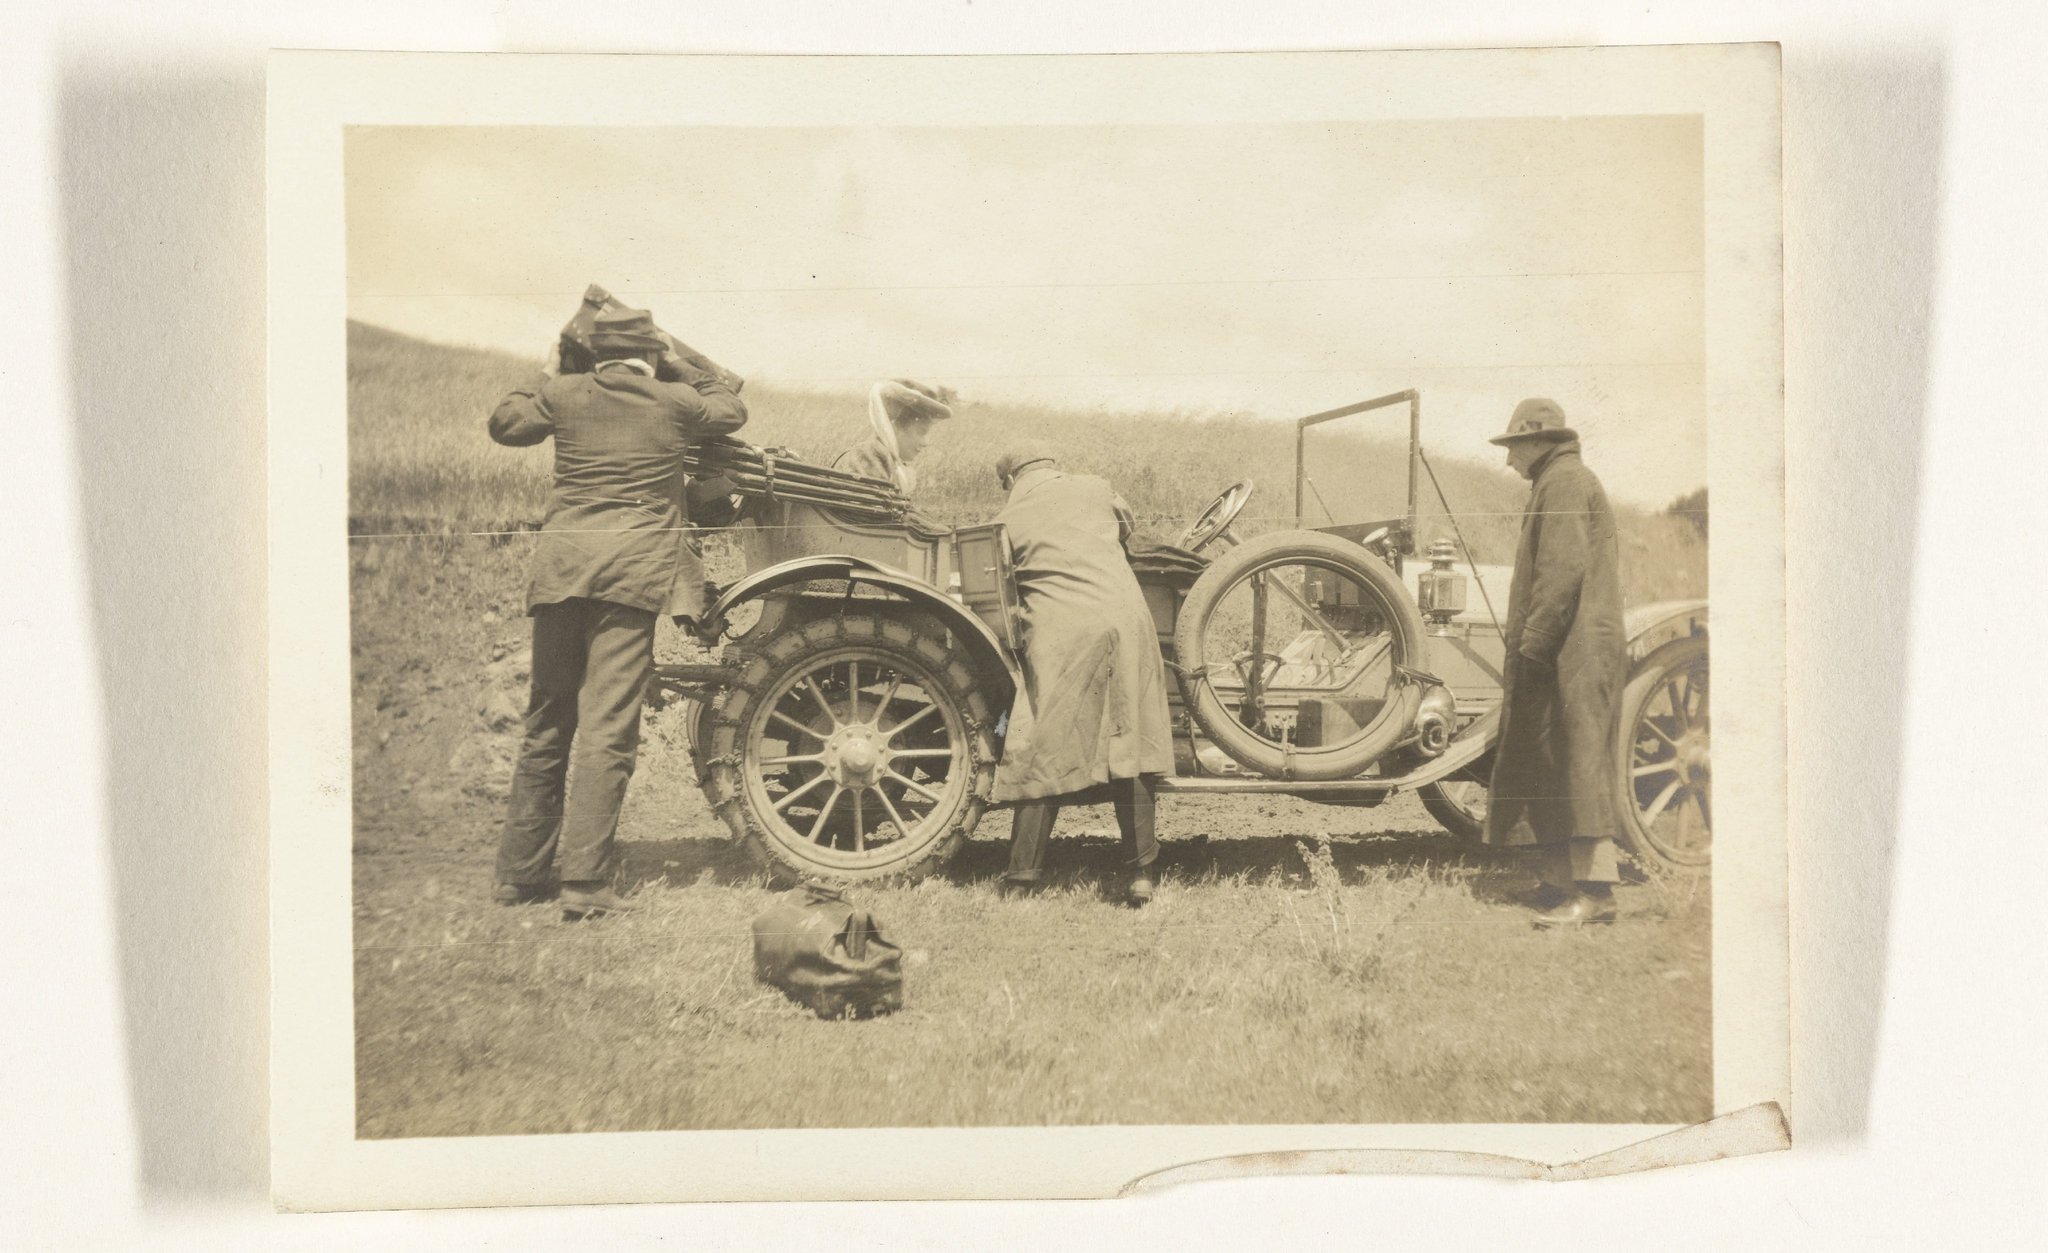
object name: photograph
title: About to start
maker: geldolph adriaan kessler (dolph)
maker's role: fotograaf, industrieel, voetballer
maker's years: 1884-1945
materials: cardboard, photographic support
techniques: gelatin silver print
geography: united states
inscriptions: title: ‘About to start’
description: Het laden van de auto voor de tocht langs de olievelden in het westen van de Verenigde Staten. Onderdeel van het fotoalbum van Dolph Kessler met opnamen die hij maakte tijdens zijn verblijf in Engeland en op een wereldreis die hij als secretaris van Henri Deterding (directeur Koninklijke Olie) ondernam naar Nederlands-Indië, Japan, China en de Verenigde Staten, tussen 1906 en 1908.